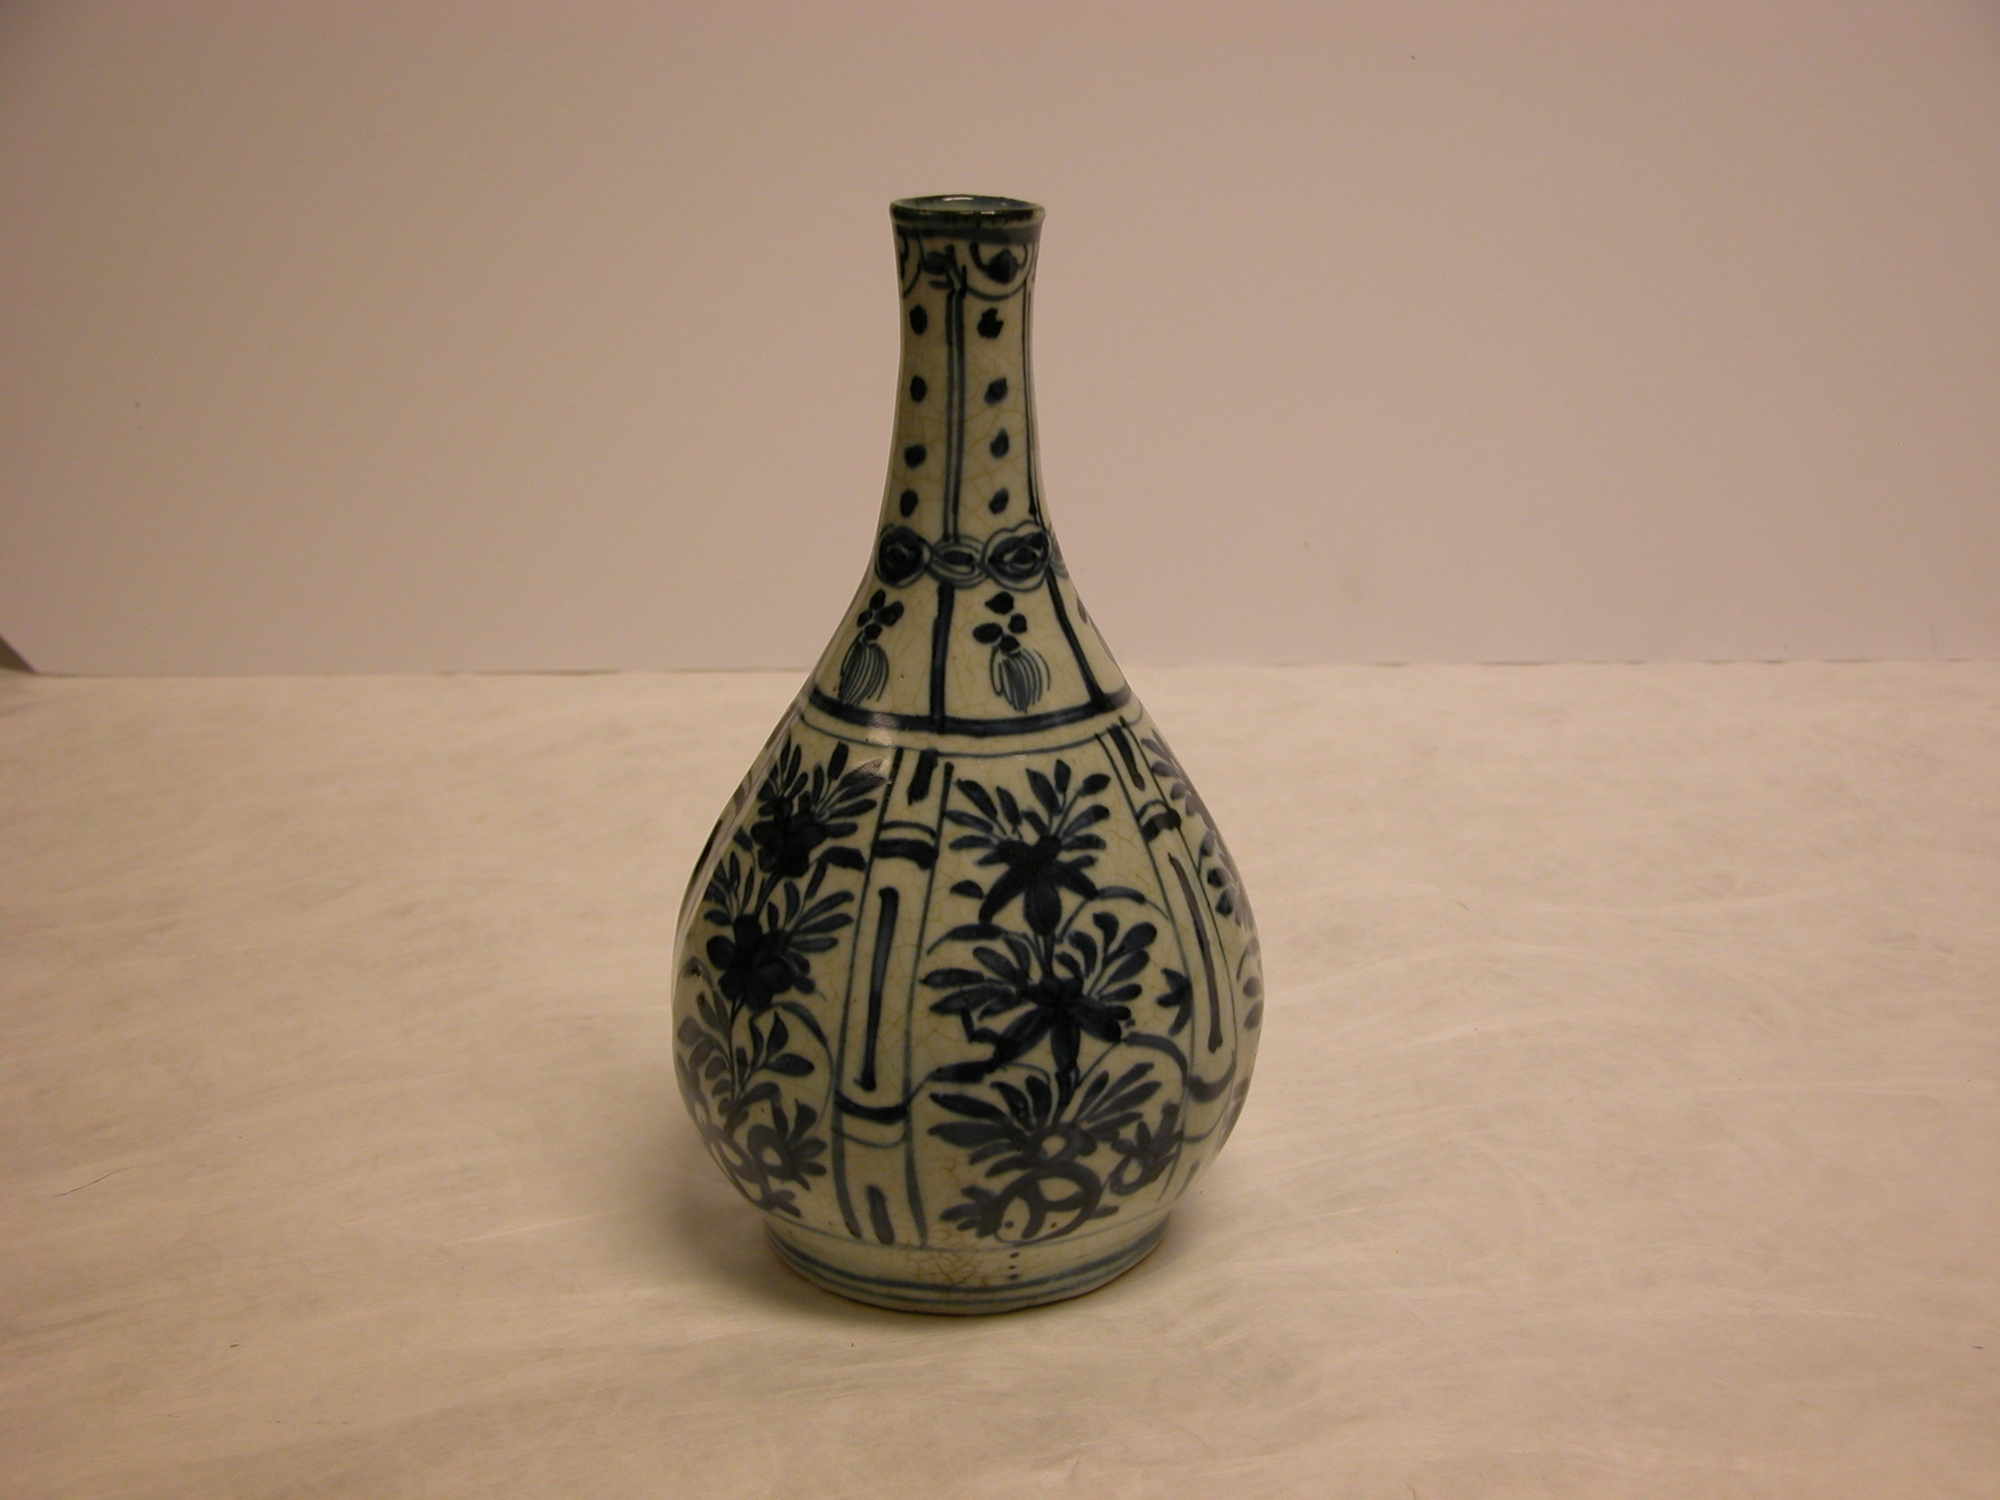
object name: vase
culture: chinese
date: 1567-1700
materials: porcelain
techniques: painting, underglaze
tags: flowers